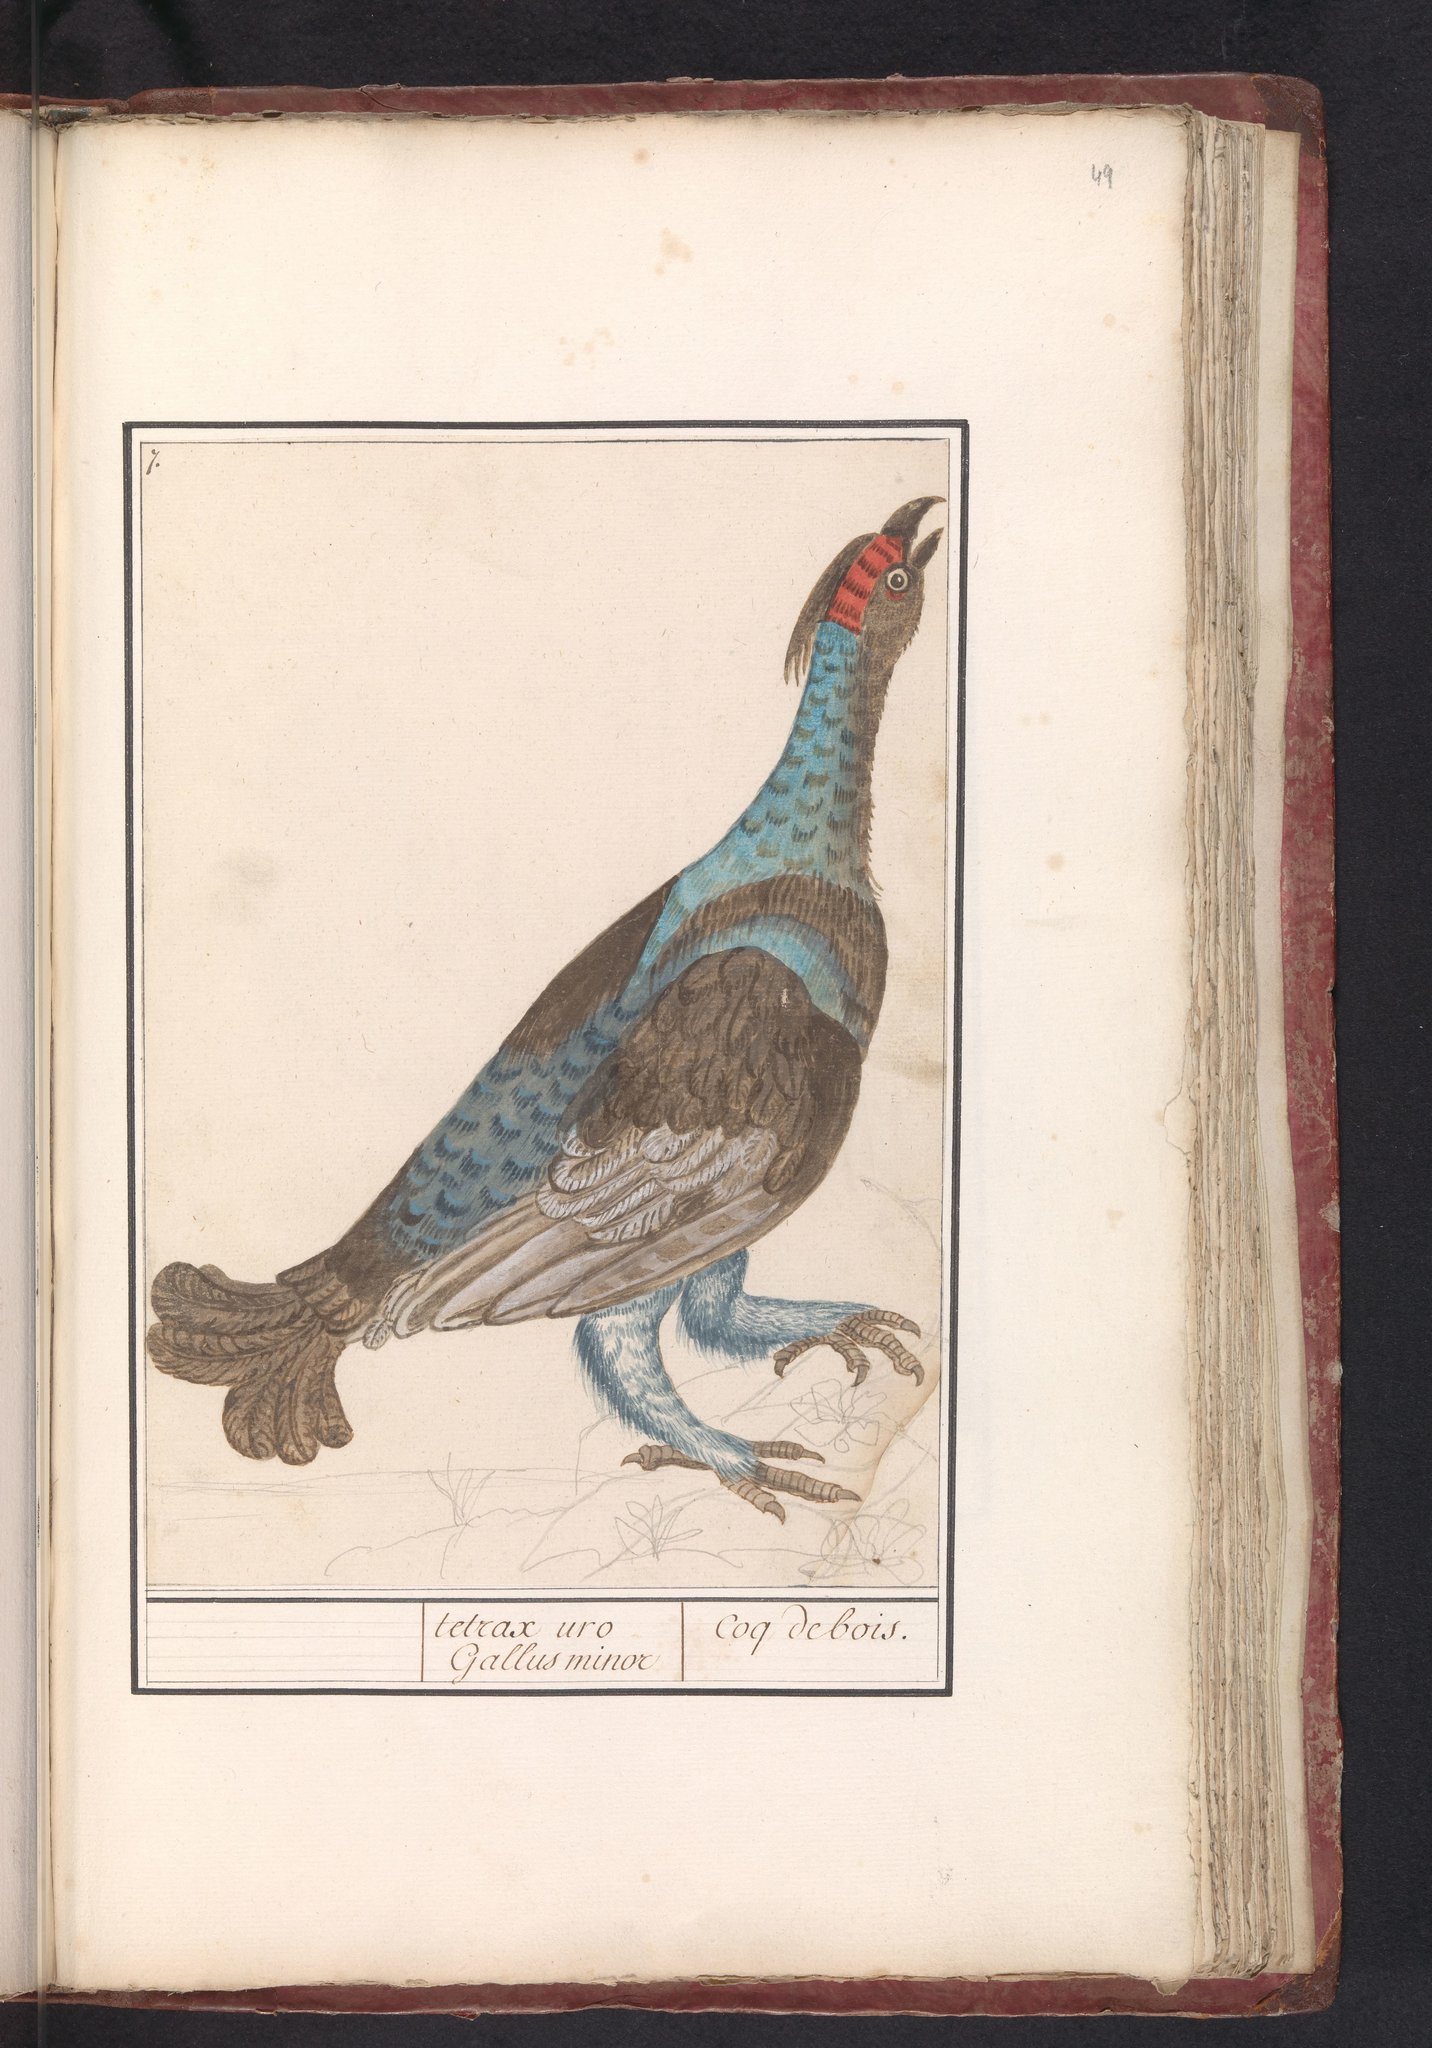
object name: drawing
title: tetrax uro Gallus minor / coq de bois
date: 1596-1610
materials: paint, paper, pencil, watercolor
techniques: brush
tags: walker and runner birds: western capercaillie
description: Auerhoen. Genummerd linksboven: 7. Onderdeel van het eerste album met tekeningen van vogels. Derde van twaalf albums met tekeningen van dieren, vogels en planten bekend rond 1600, gemaakt in opdracht van keizer Rudolf II. Met toelichting in Nederlands, Latijn en Frans.